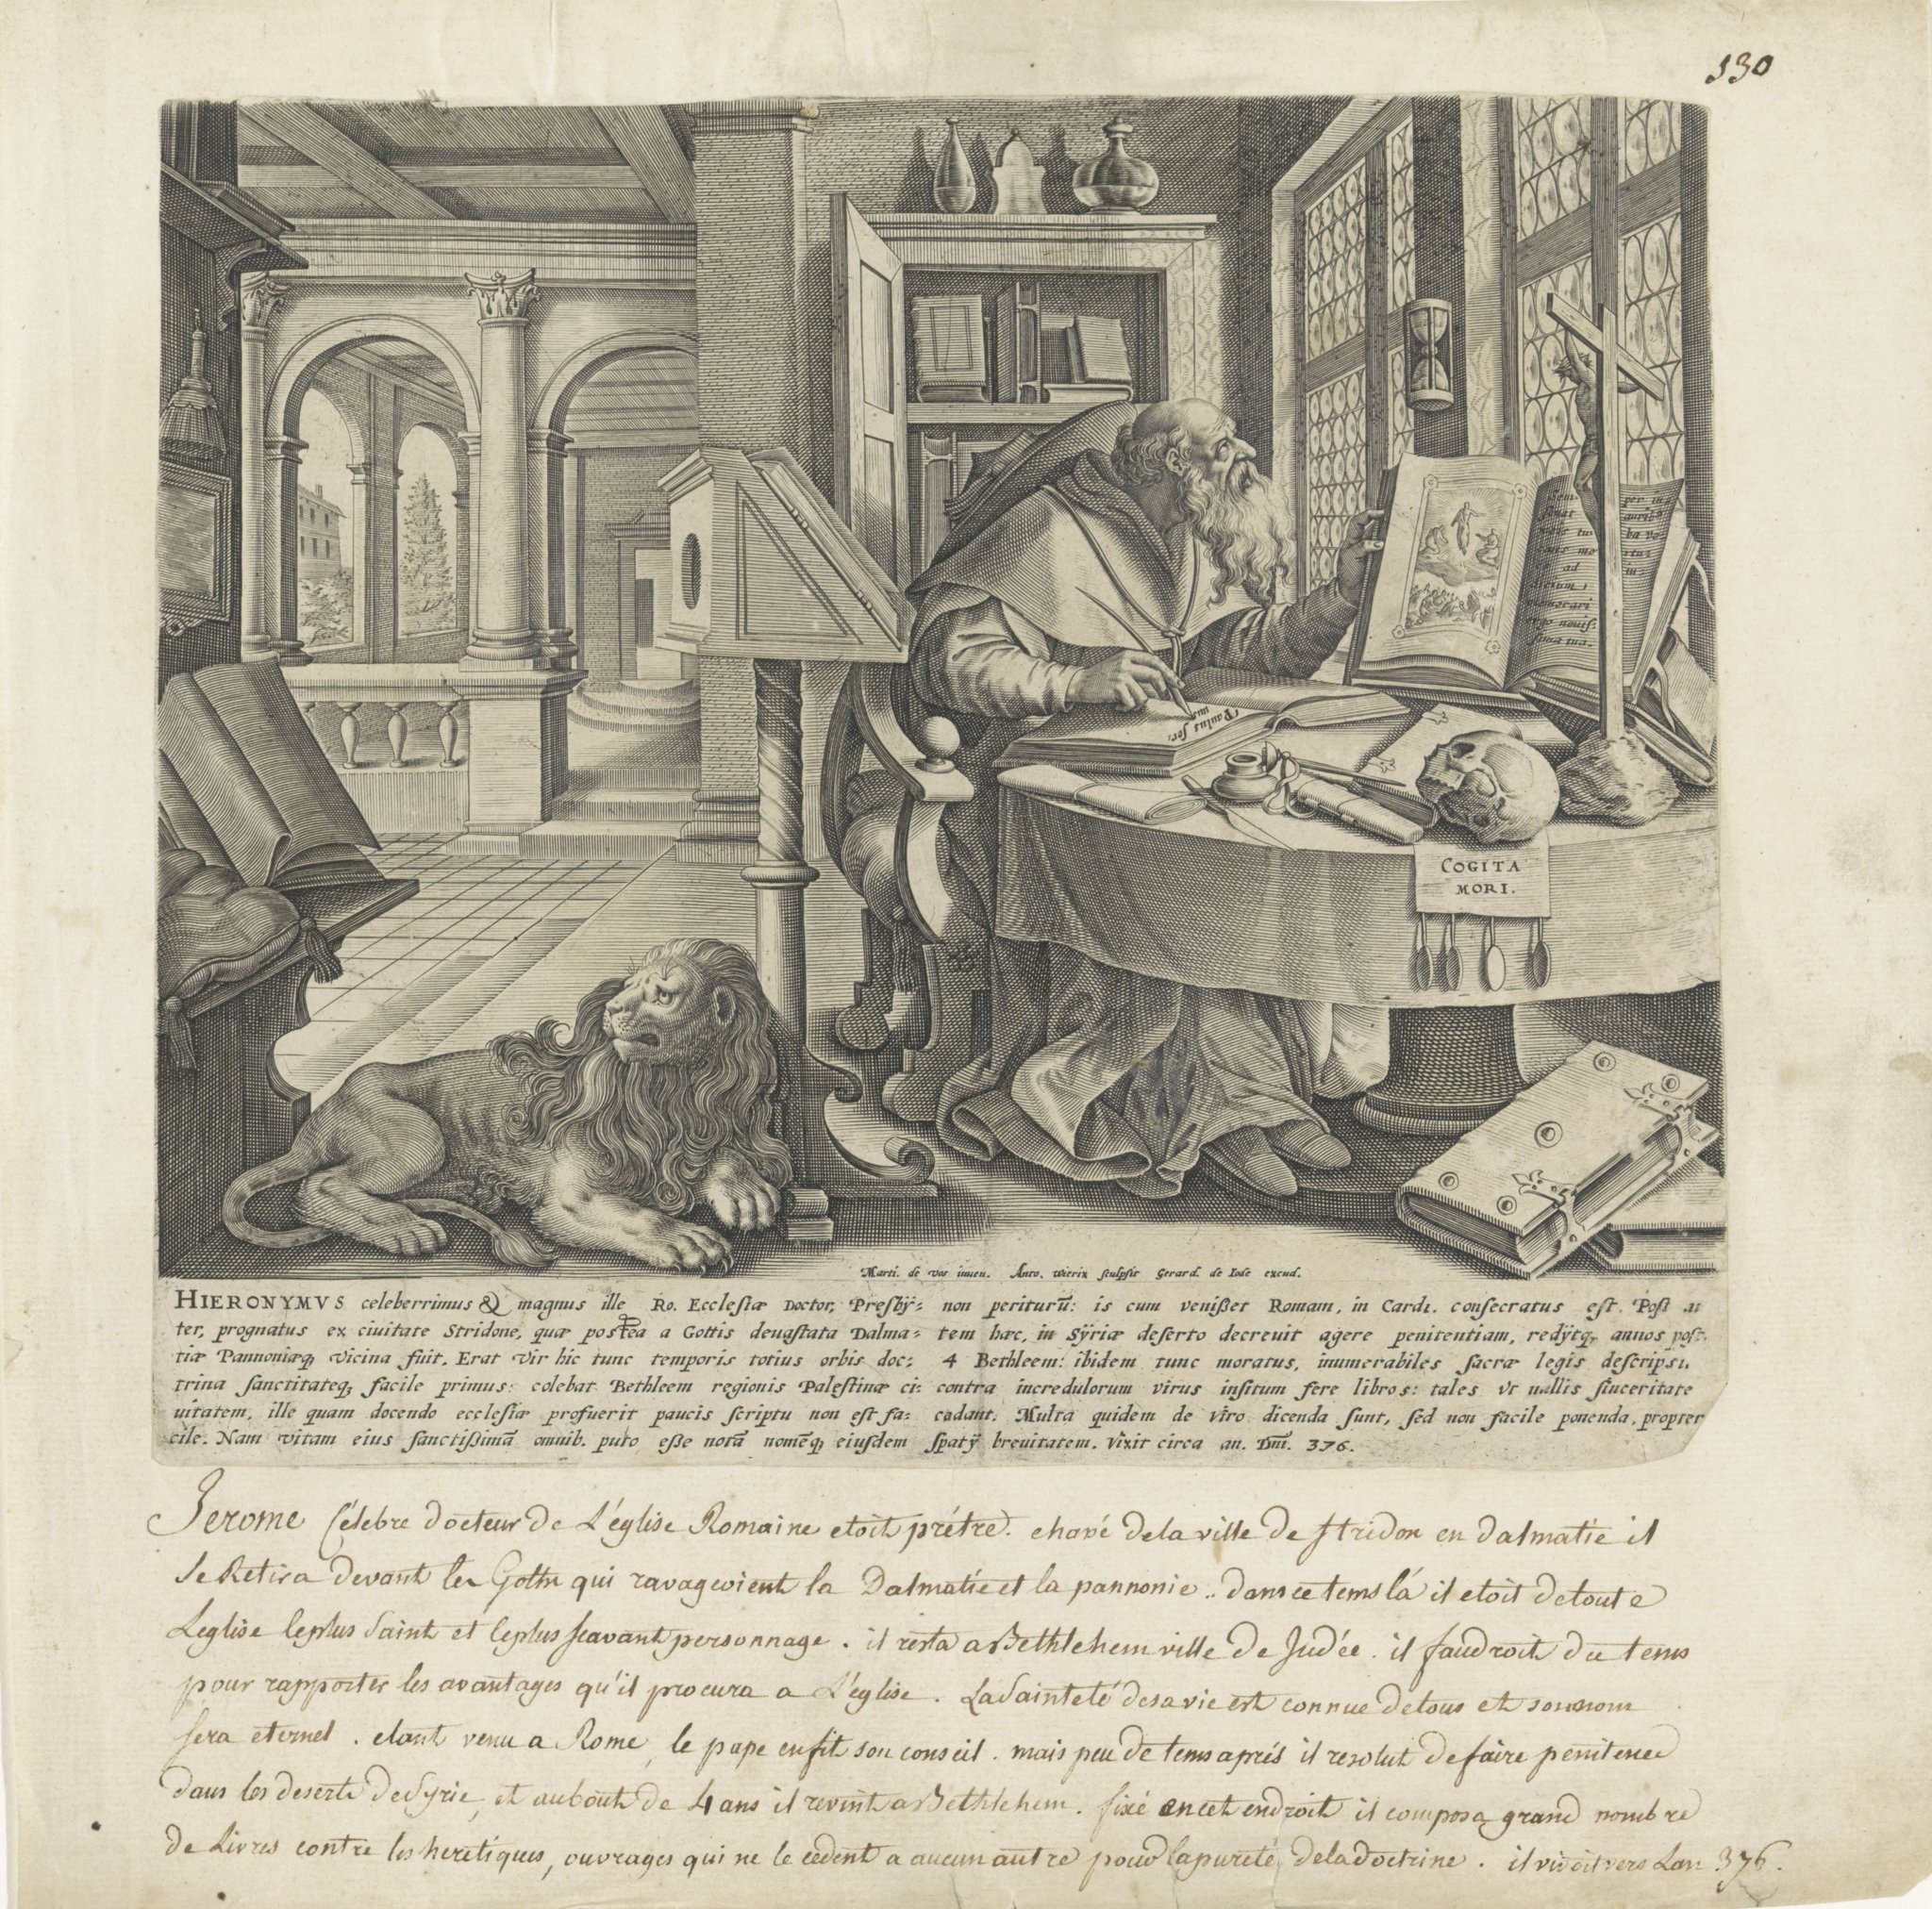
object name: print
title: Thesaurus sacrarum historiarum veteris testamenti (...)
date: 1585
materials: paper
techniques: engraving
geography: antwerp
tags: st. jerome as doctor of the latin church in his study with book, pen and ink; lion and cardinal's hat beside him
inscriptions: collector's mark: Lugt 2228, number: ‘130’, inscription: ‘Jerome celebre docteur de l'eglise Romaine [...] pour la purité de la doctrine. il vivoit vers lan 376.’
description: De H. Hieronymus is aan het werk in zijn studeervertrek. Hij bekijkt een opengeslagen Bijbel en schrijft in een boek. Op tafel staan een crucifix en een schedel. Op de grond ligt de leeuw. Onder de voorstelling een verklarende tekst in het Latijn.